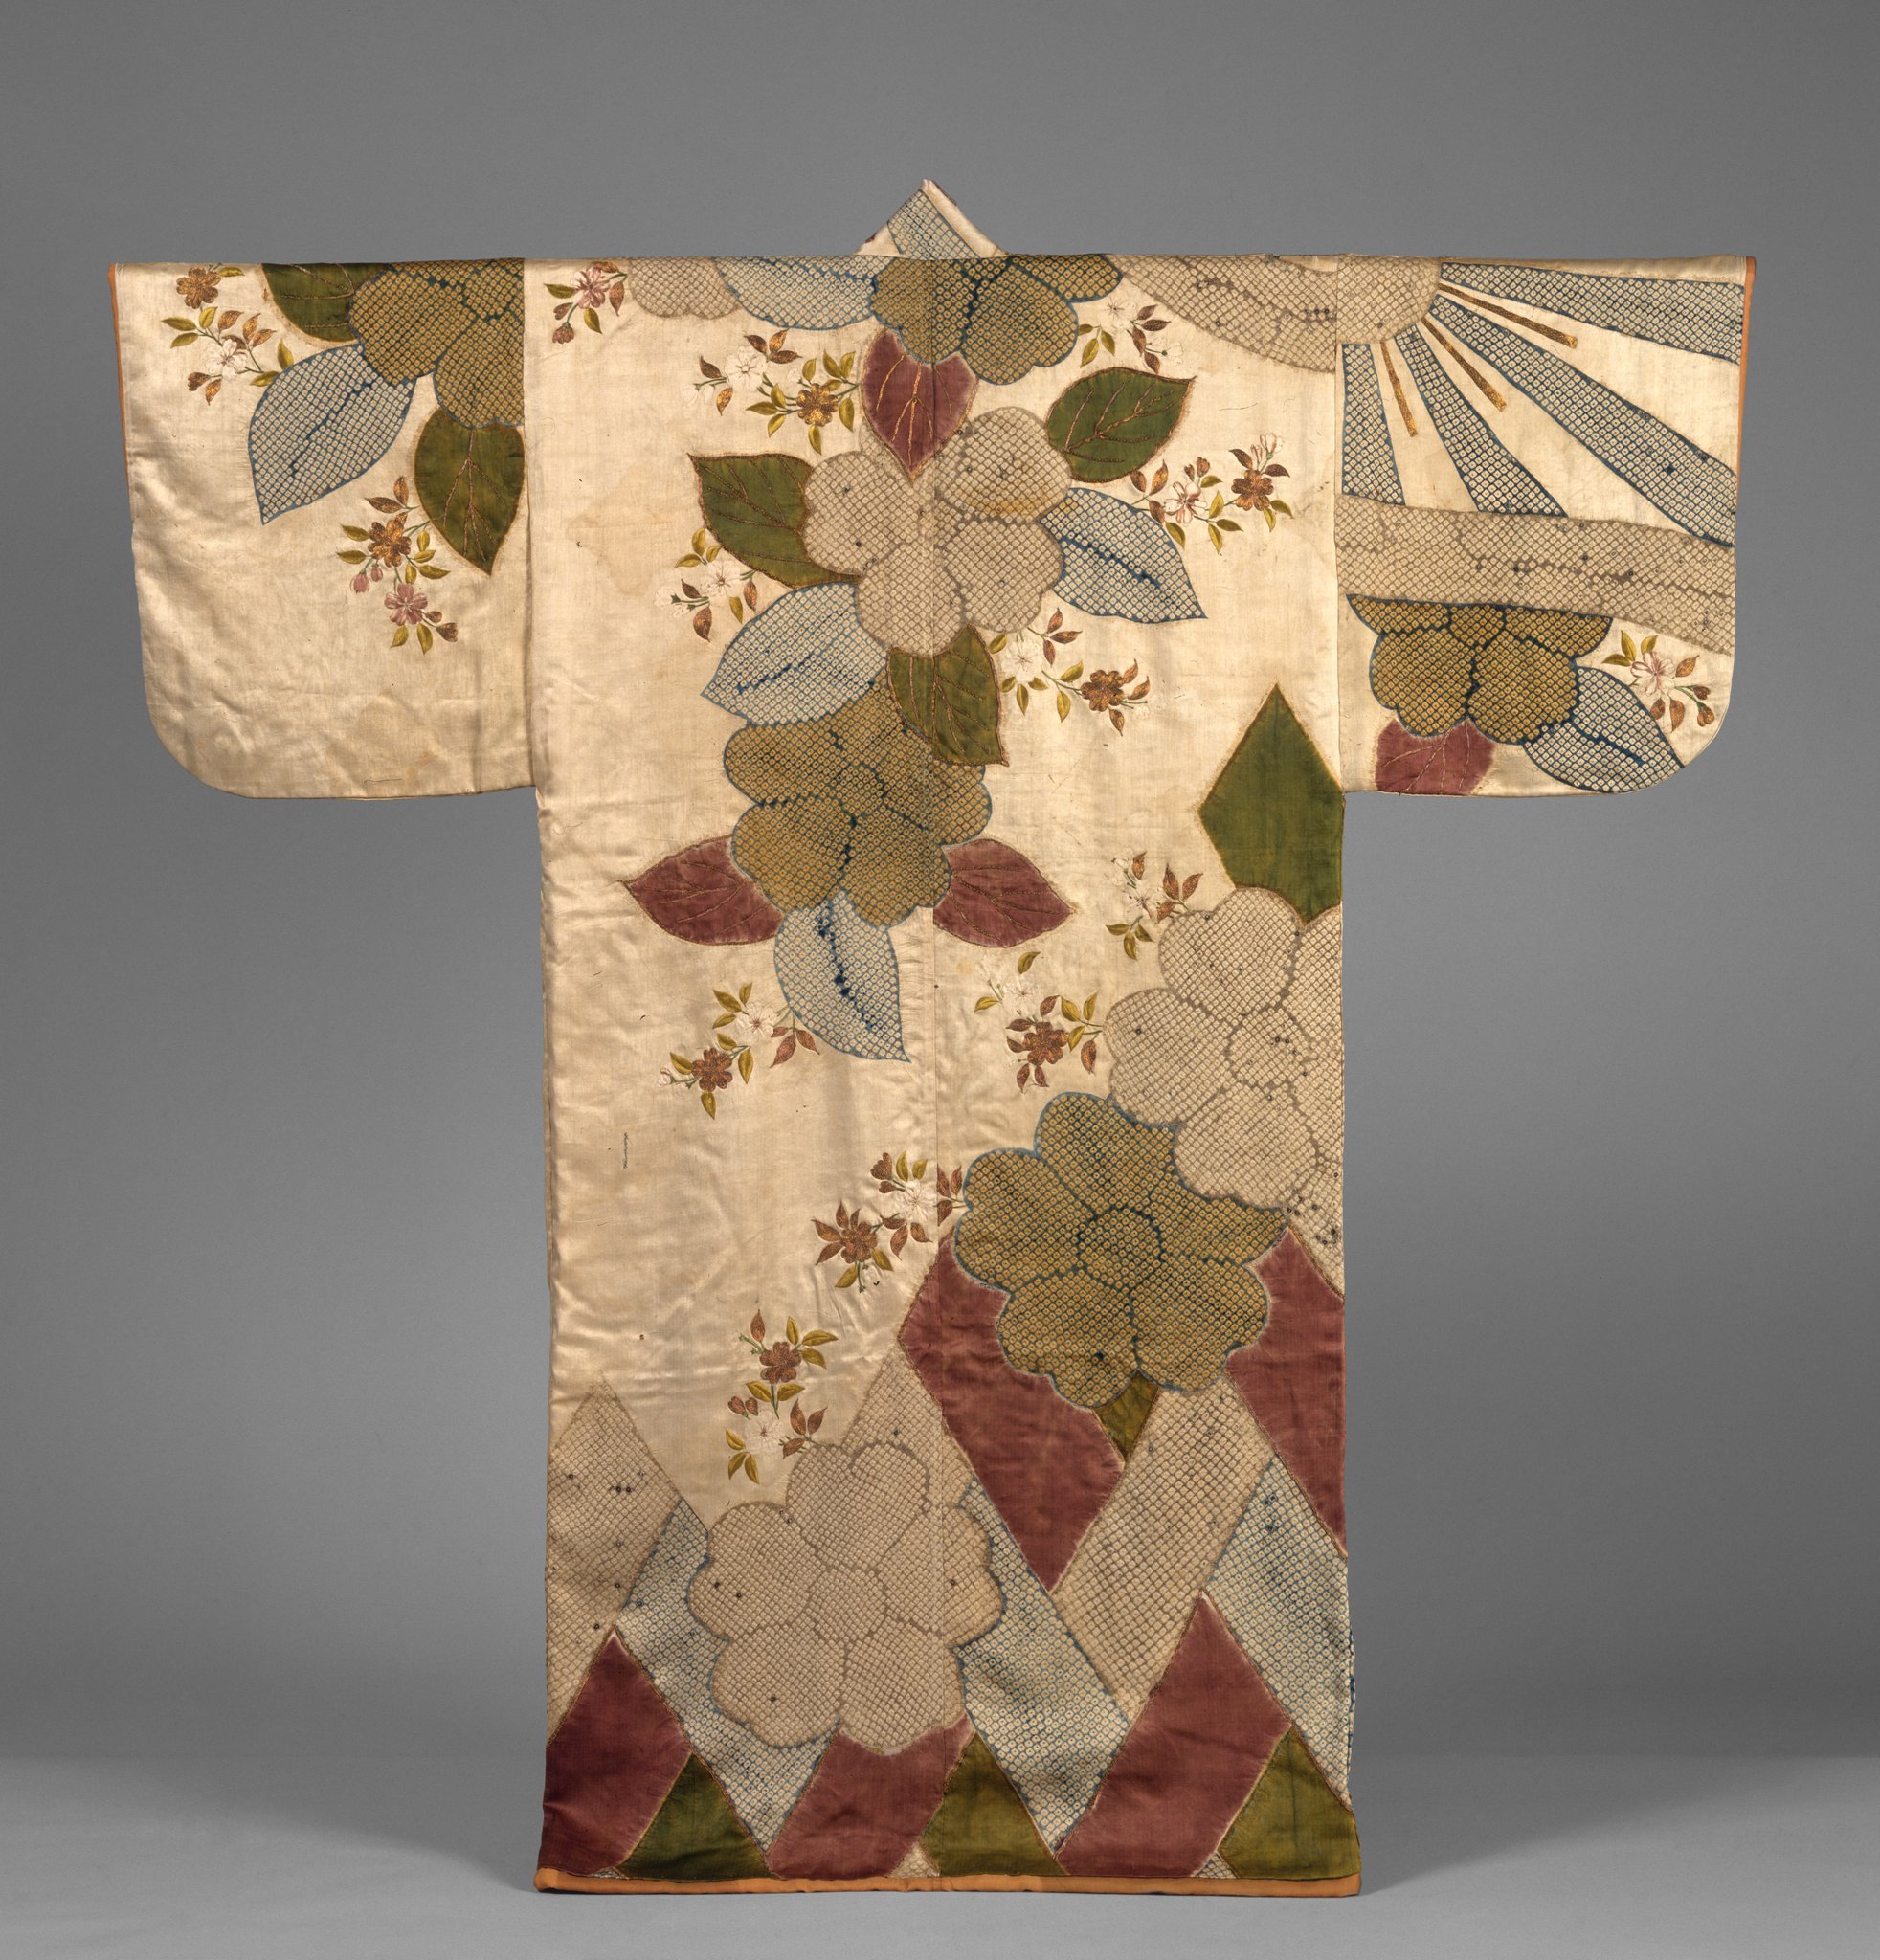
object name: kosode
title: Robe (Kosode) with Cherry Blossoms and Cypress Fence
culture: japanese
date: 1651-1700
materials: metal thread, textile, silk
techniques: damask, embroidery, resist